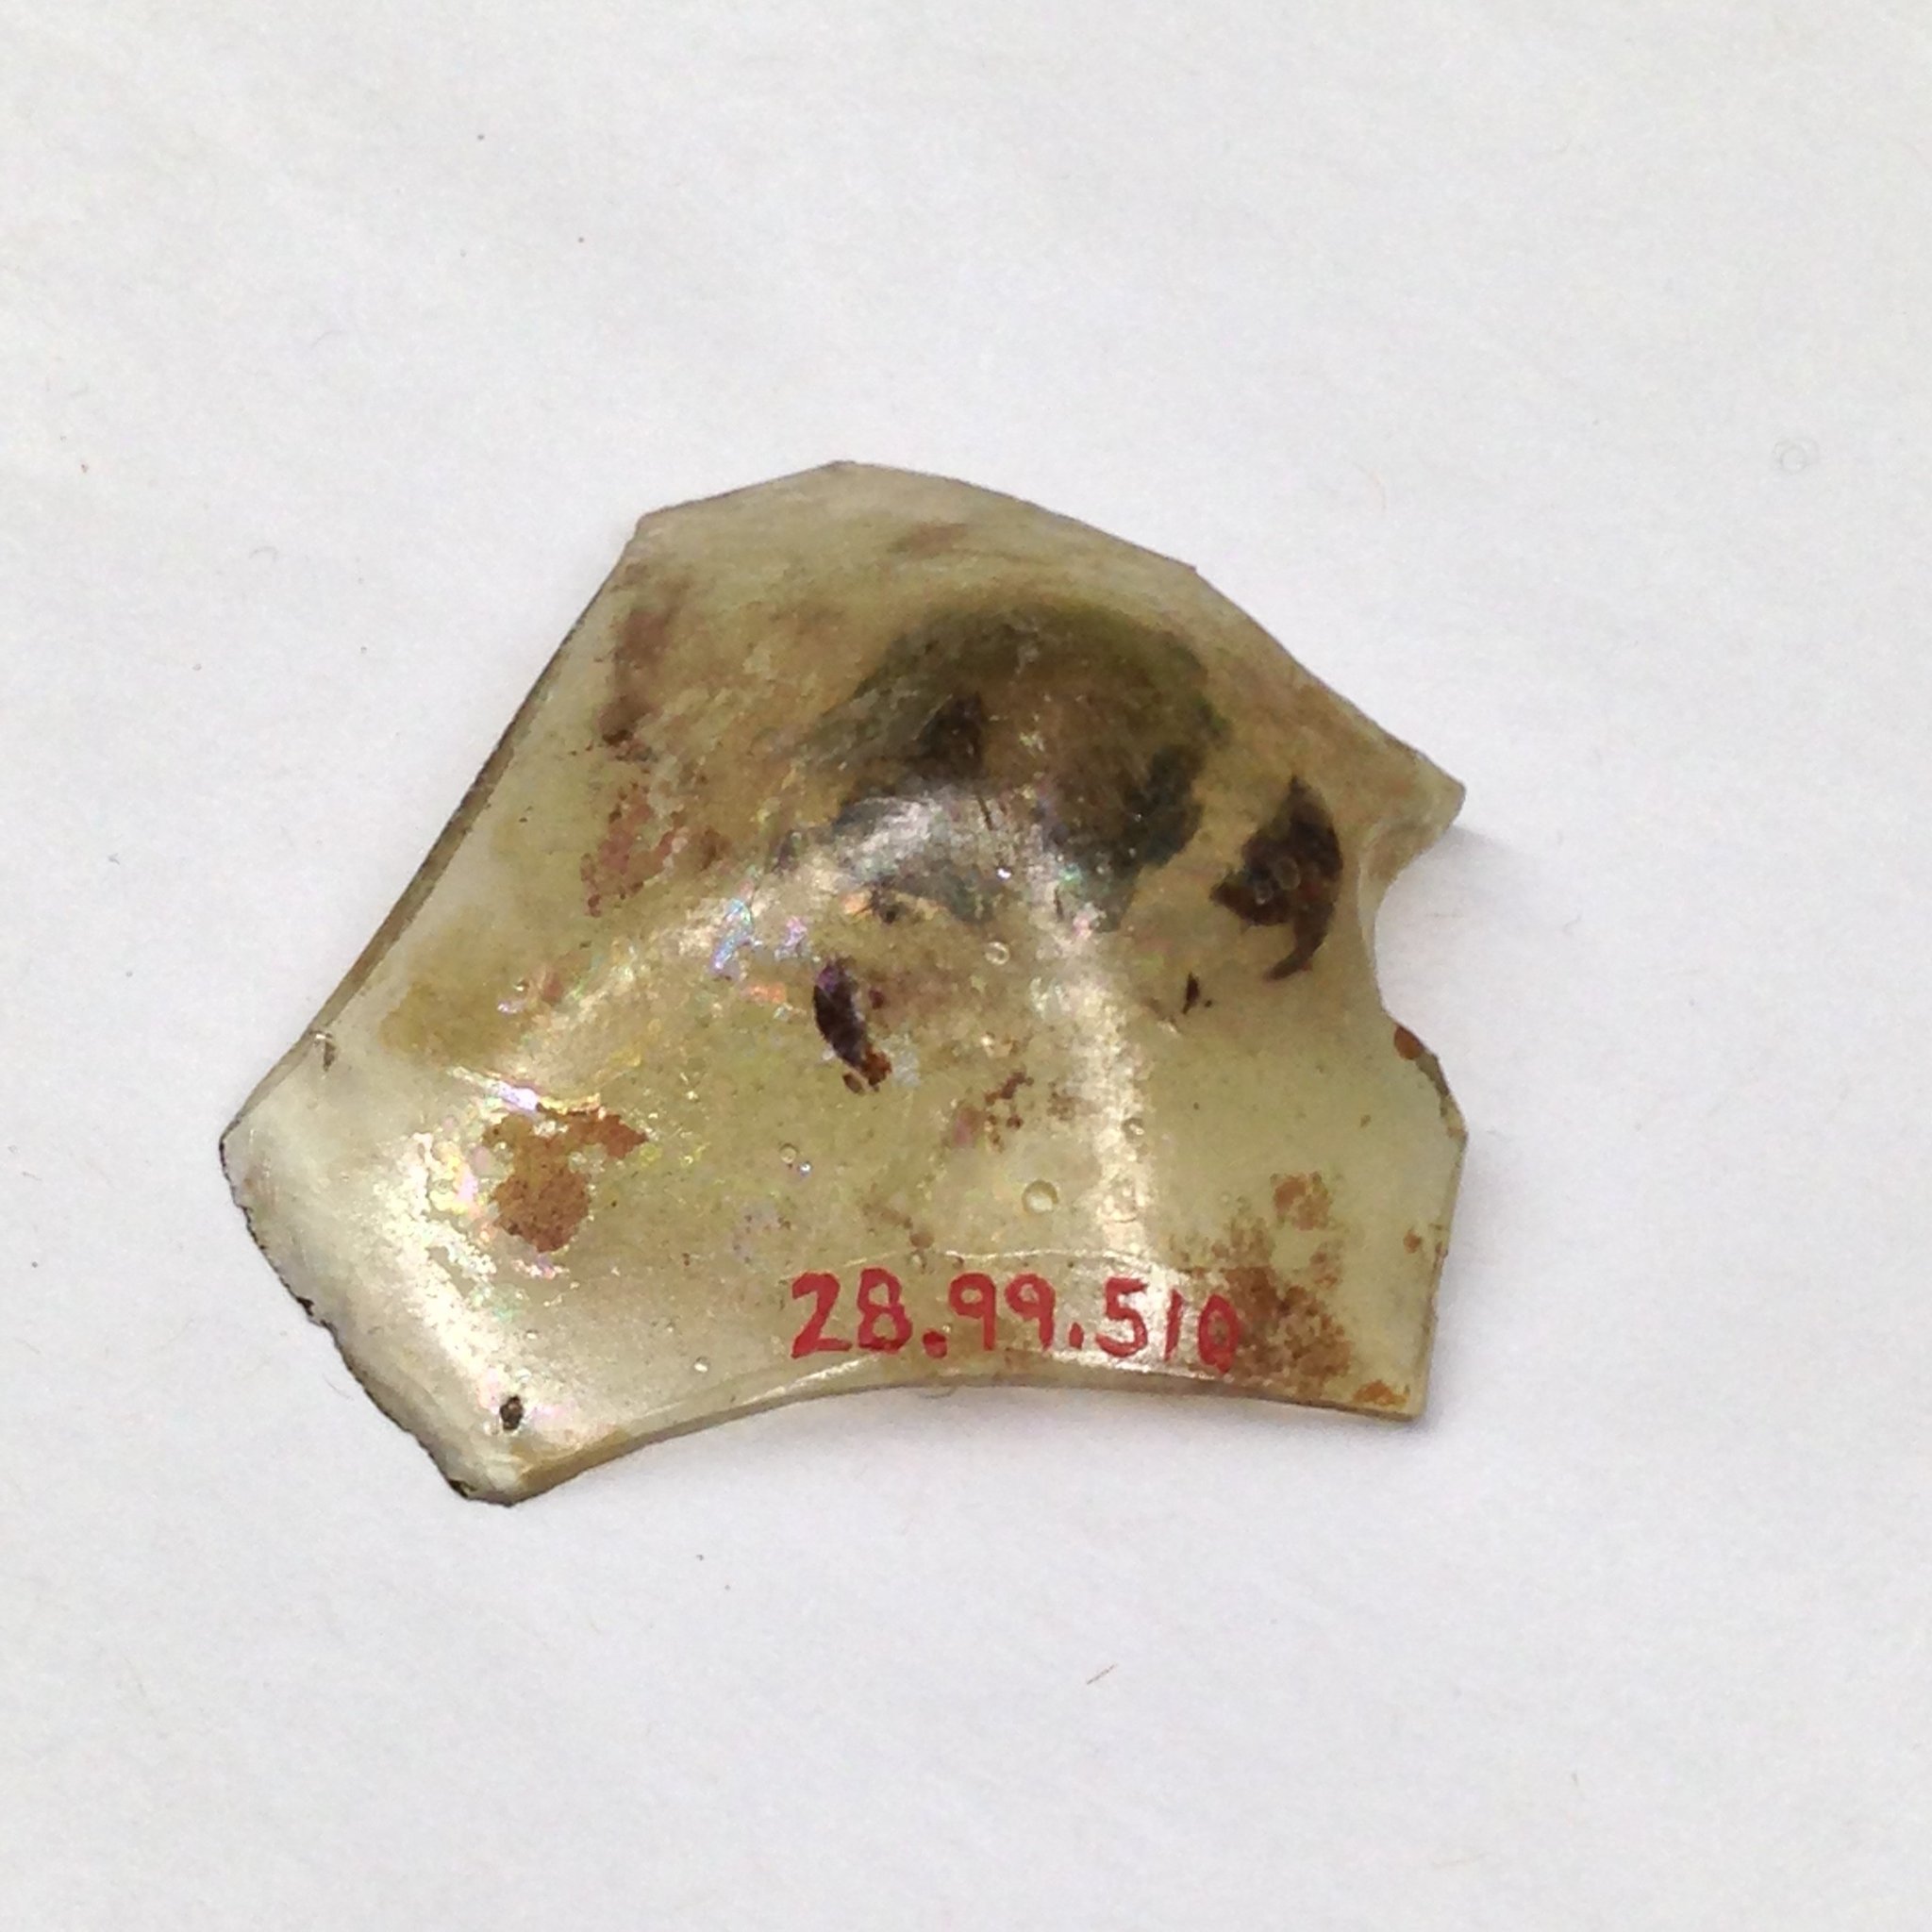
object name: fragment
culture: european or middle eastern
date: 1150-1250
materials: ceramic, glass